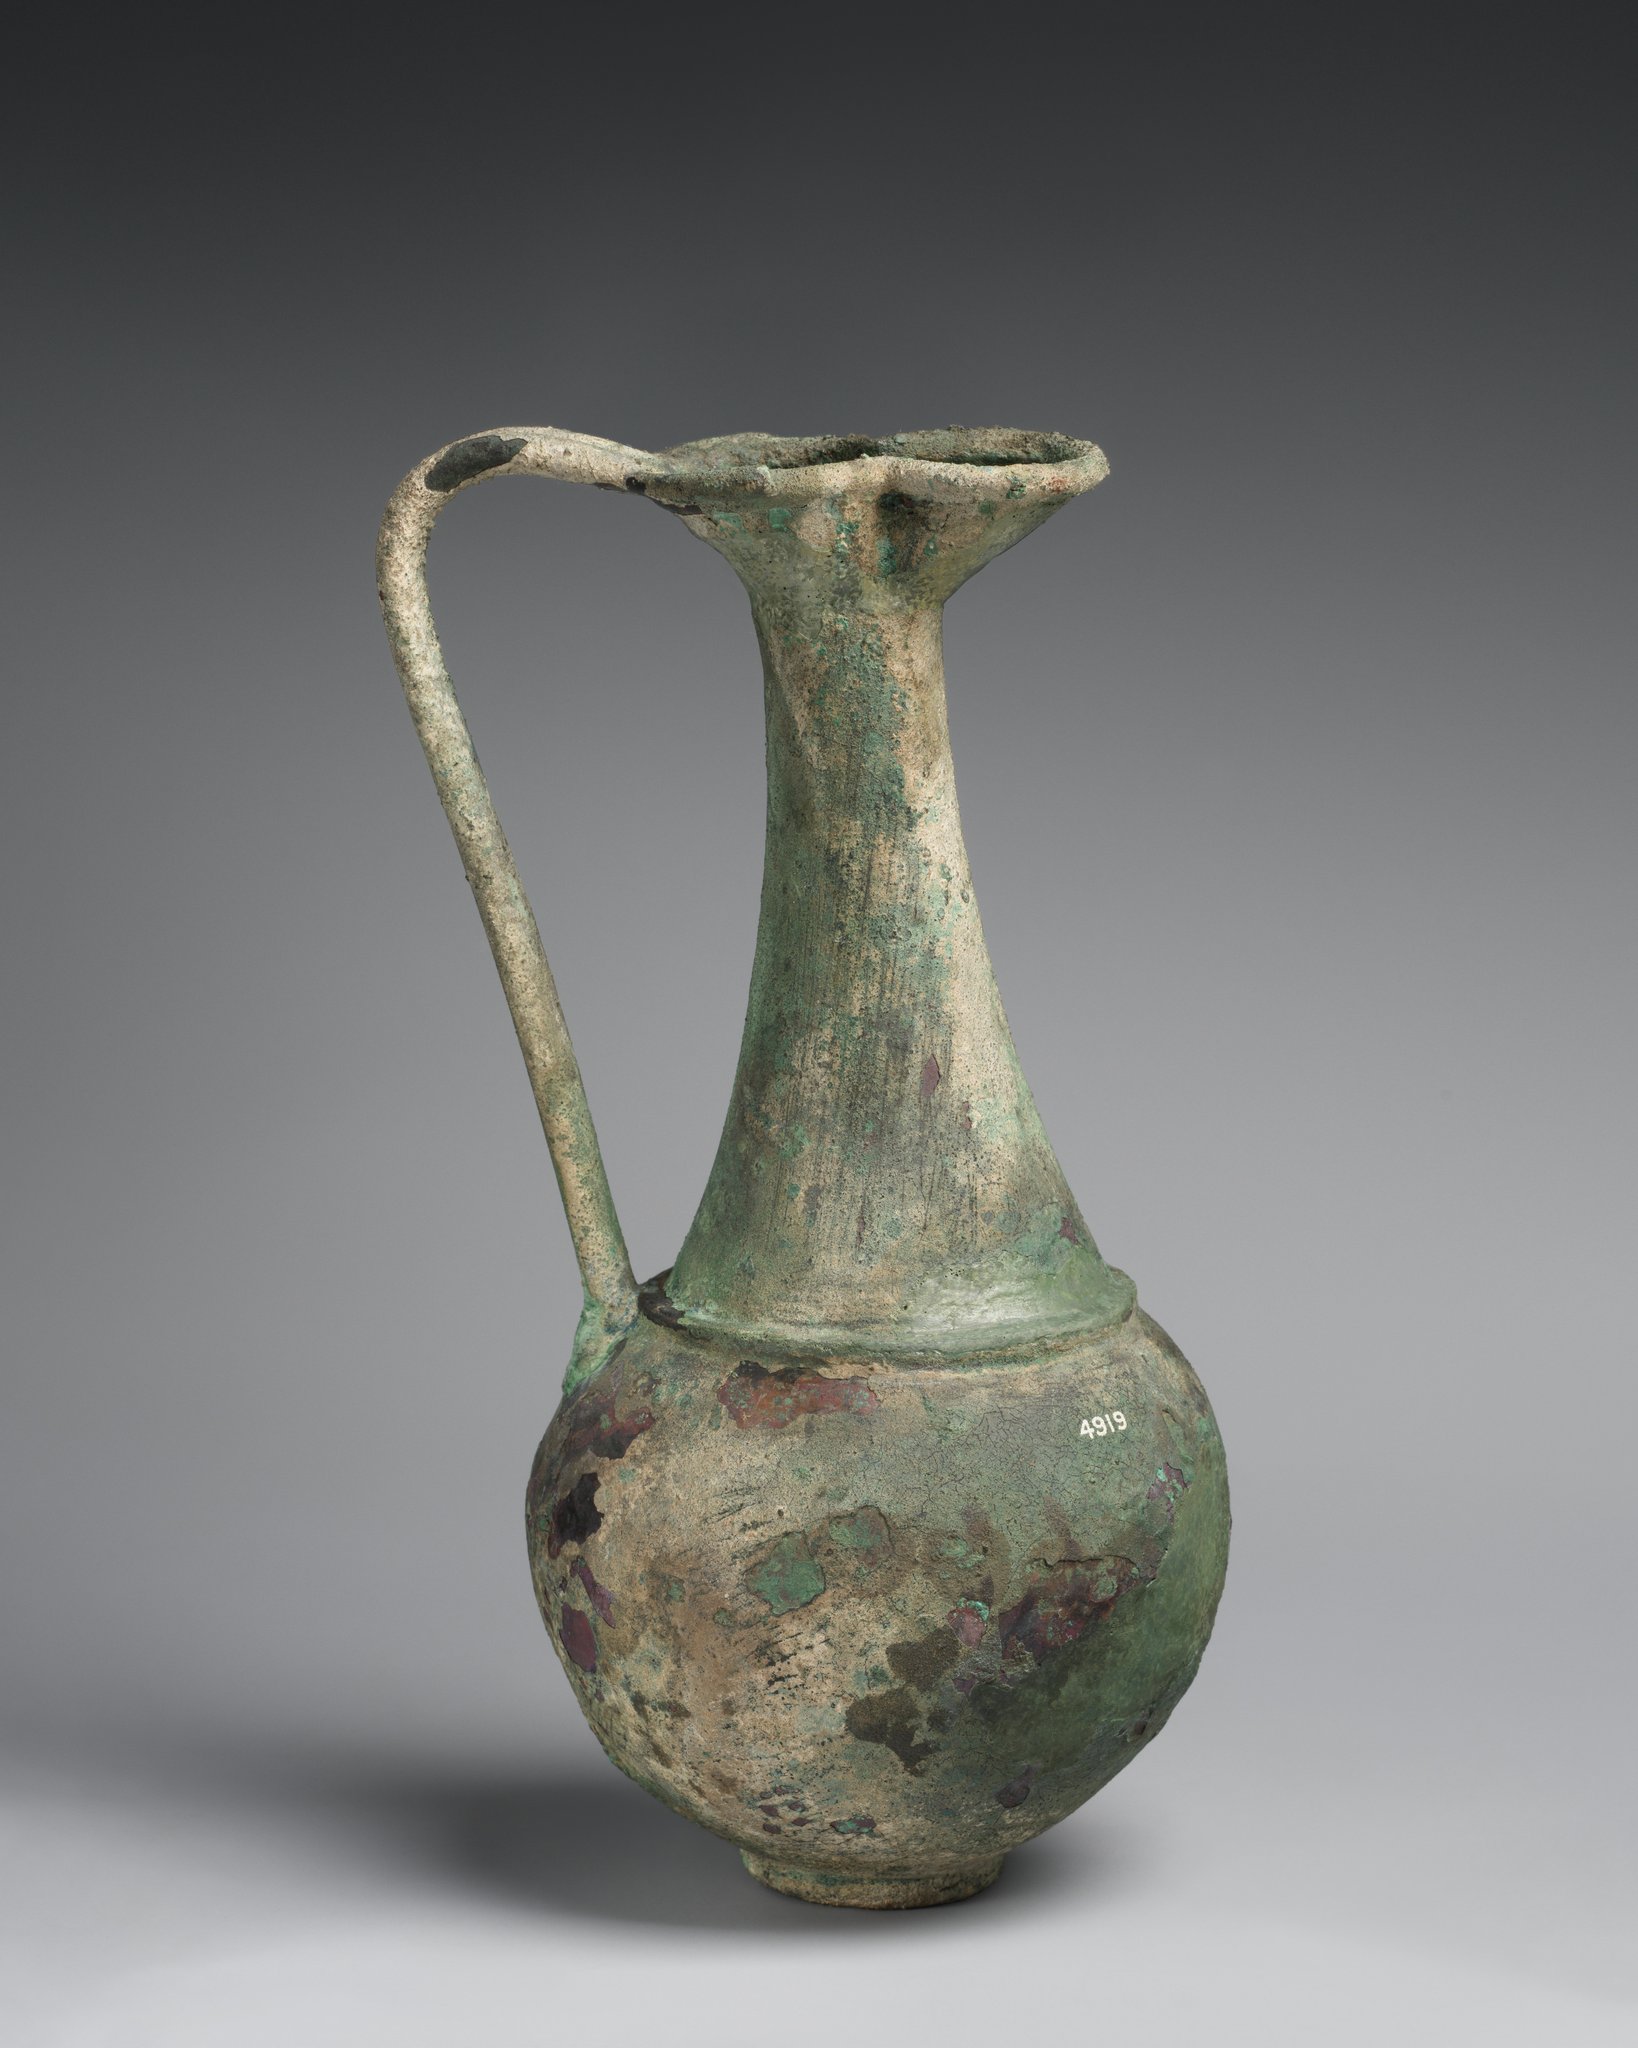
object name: handle of a jug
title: Jug, one handle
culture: cypriot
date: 3900 BCE-100 CE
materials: bronze